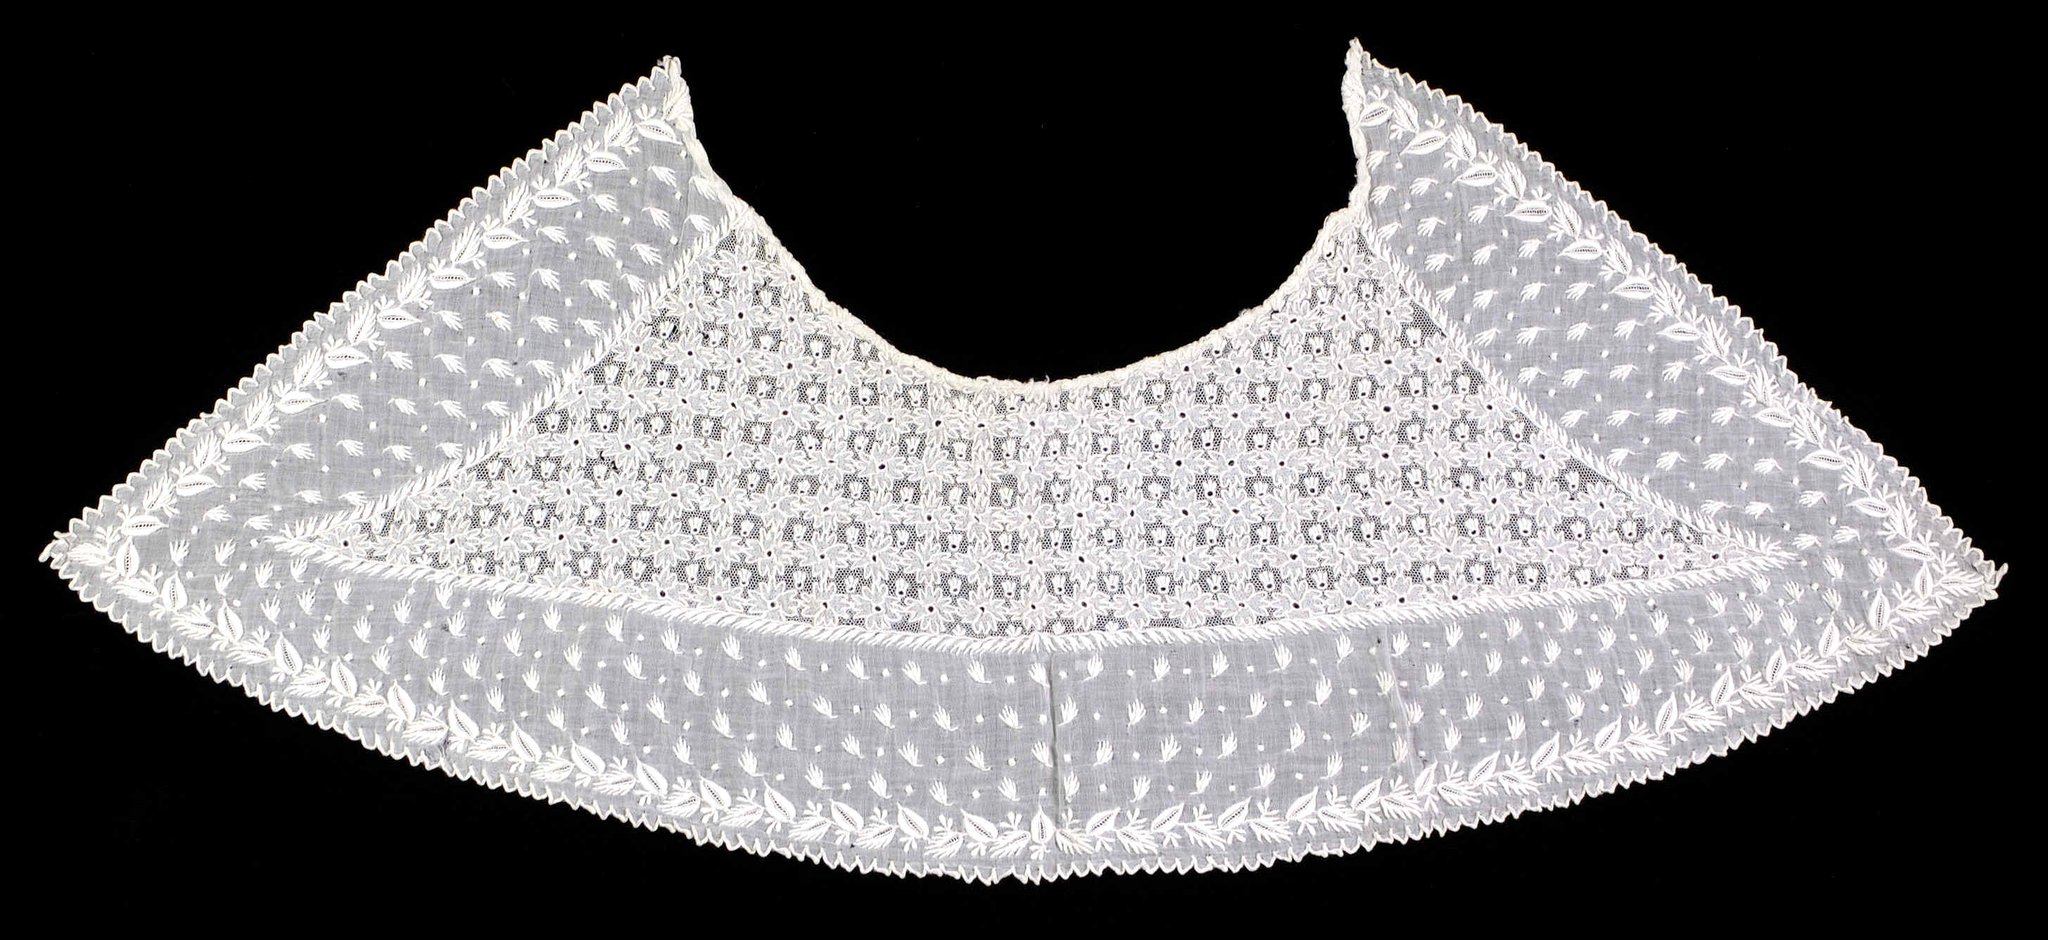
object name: collar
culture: american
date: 1820-1830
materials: cotton